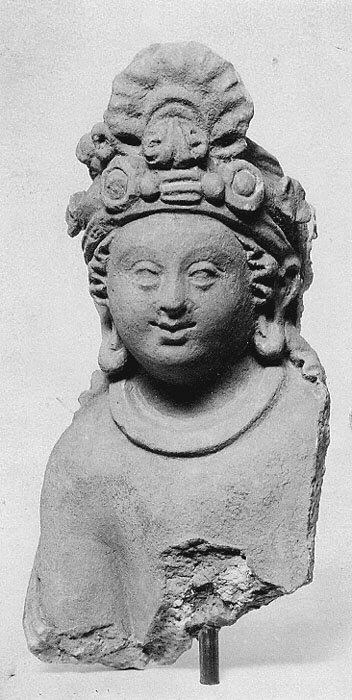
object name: relief fragment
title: Bodhisattva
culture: afghan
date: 301-500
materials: plaster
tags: gandharan,buddhism,bodhisattvas